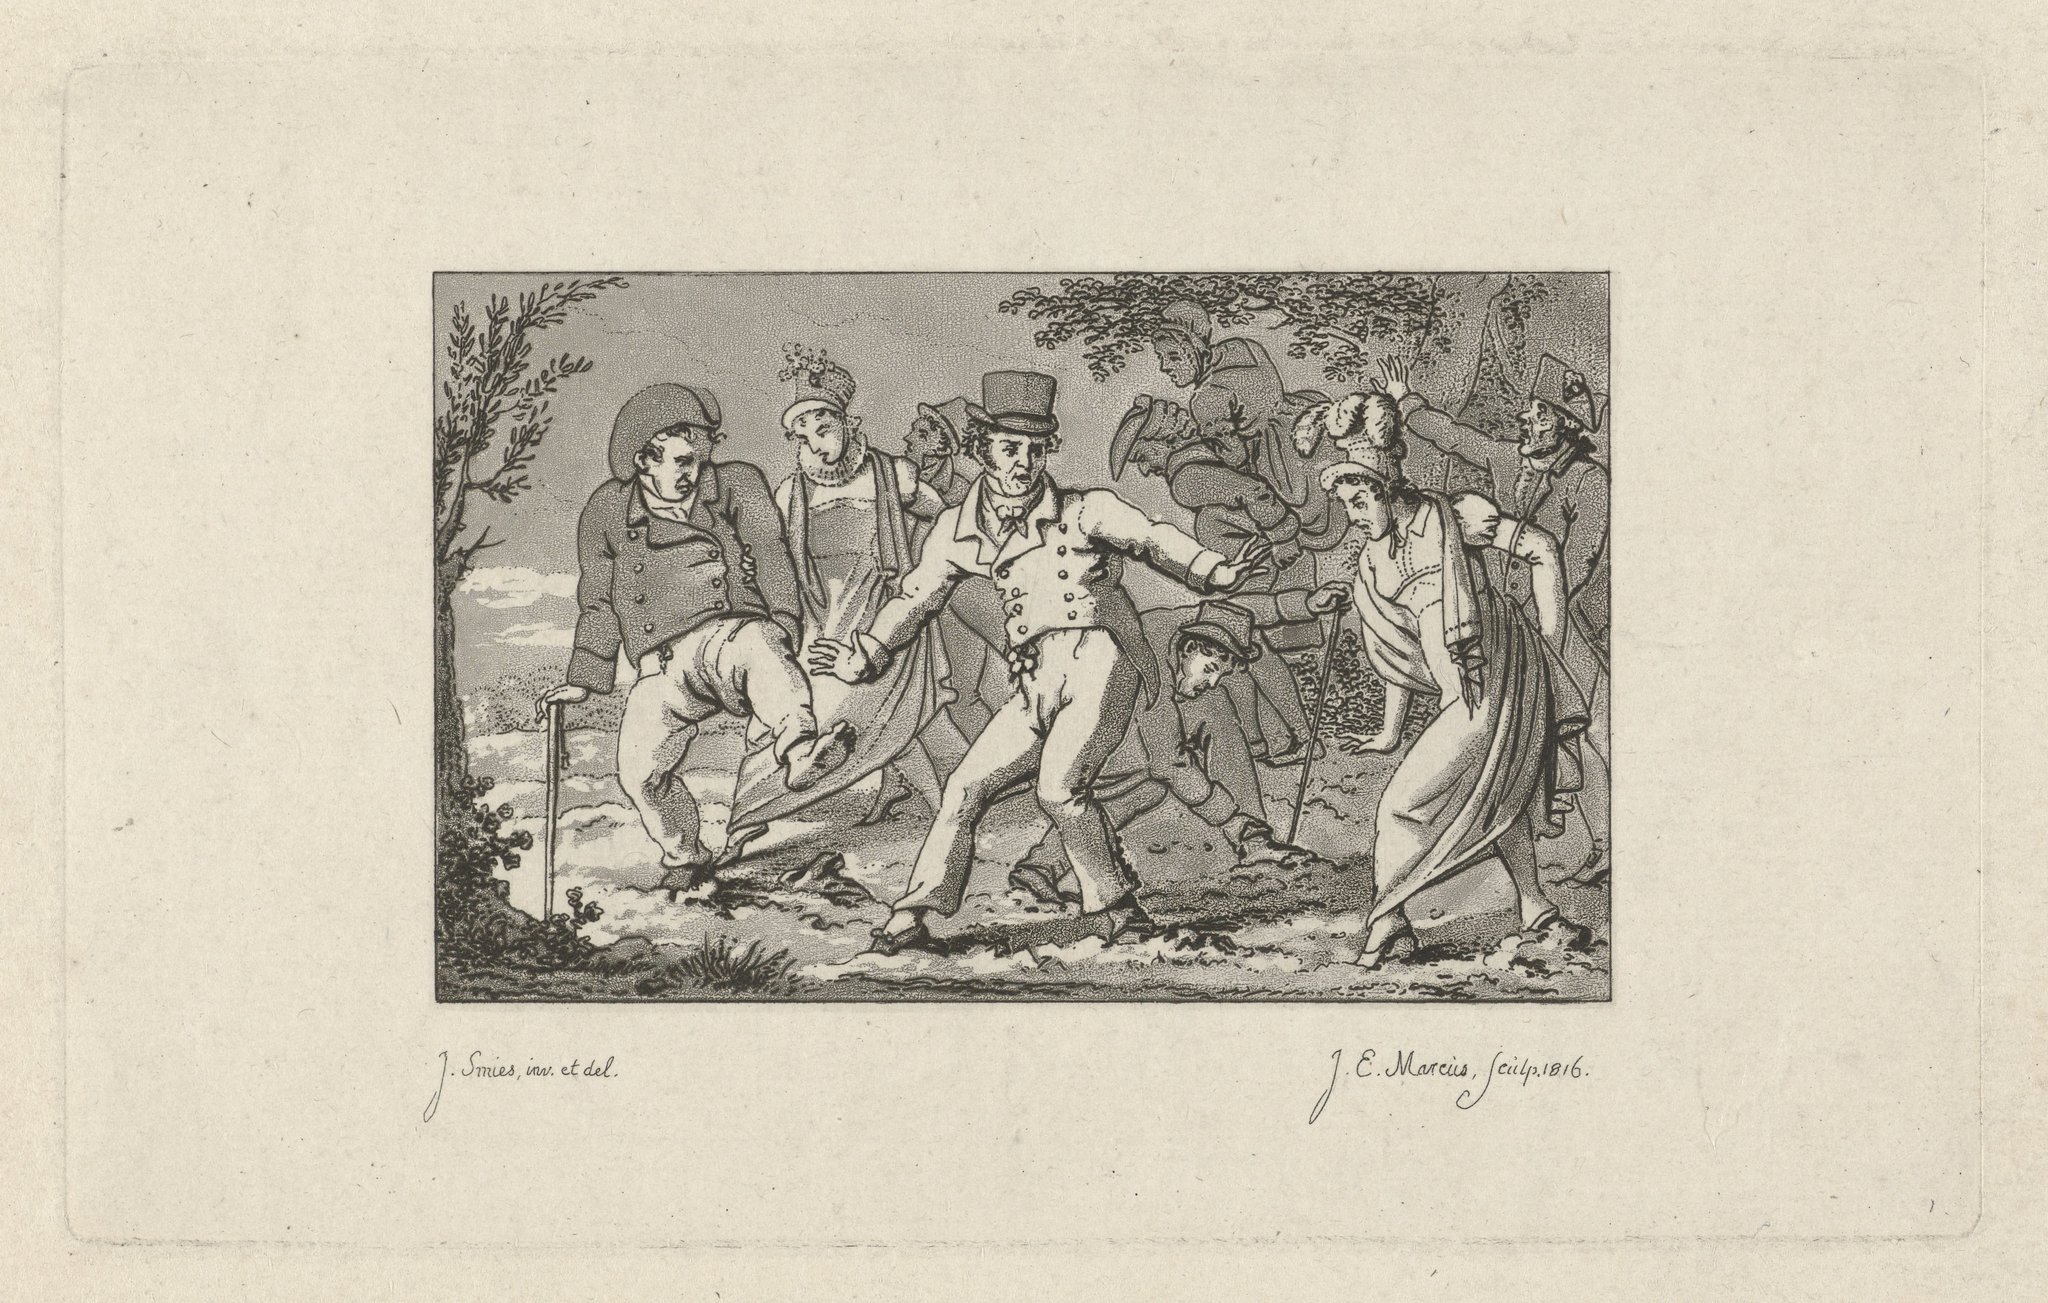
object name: print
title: Gezelschap in een bos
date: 1816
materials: paper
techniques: aquatint, etching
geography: amsterdam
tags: group dancing (+ out of doors (sports, games, etc.))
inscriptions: collector's mark: Lugt 2228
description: Verschillende heren en dames, maar ook soldaten met blote voeten maken een rondedans in een landschap. De man met hoge hoed lijkt een afwerend gebaar te maken.